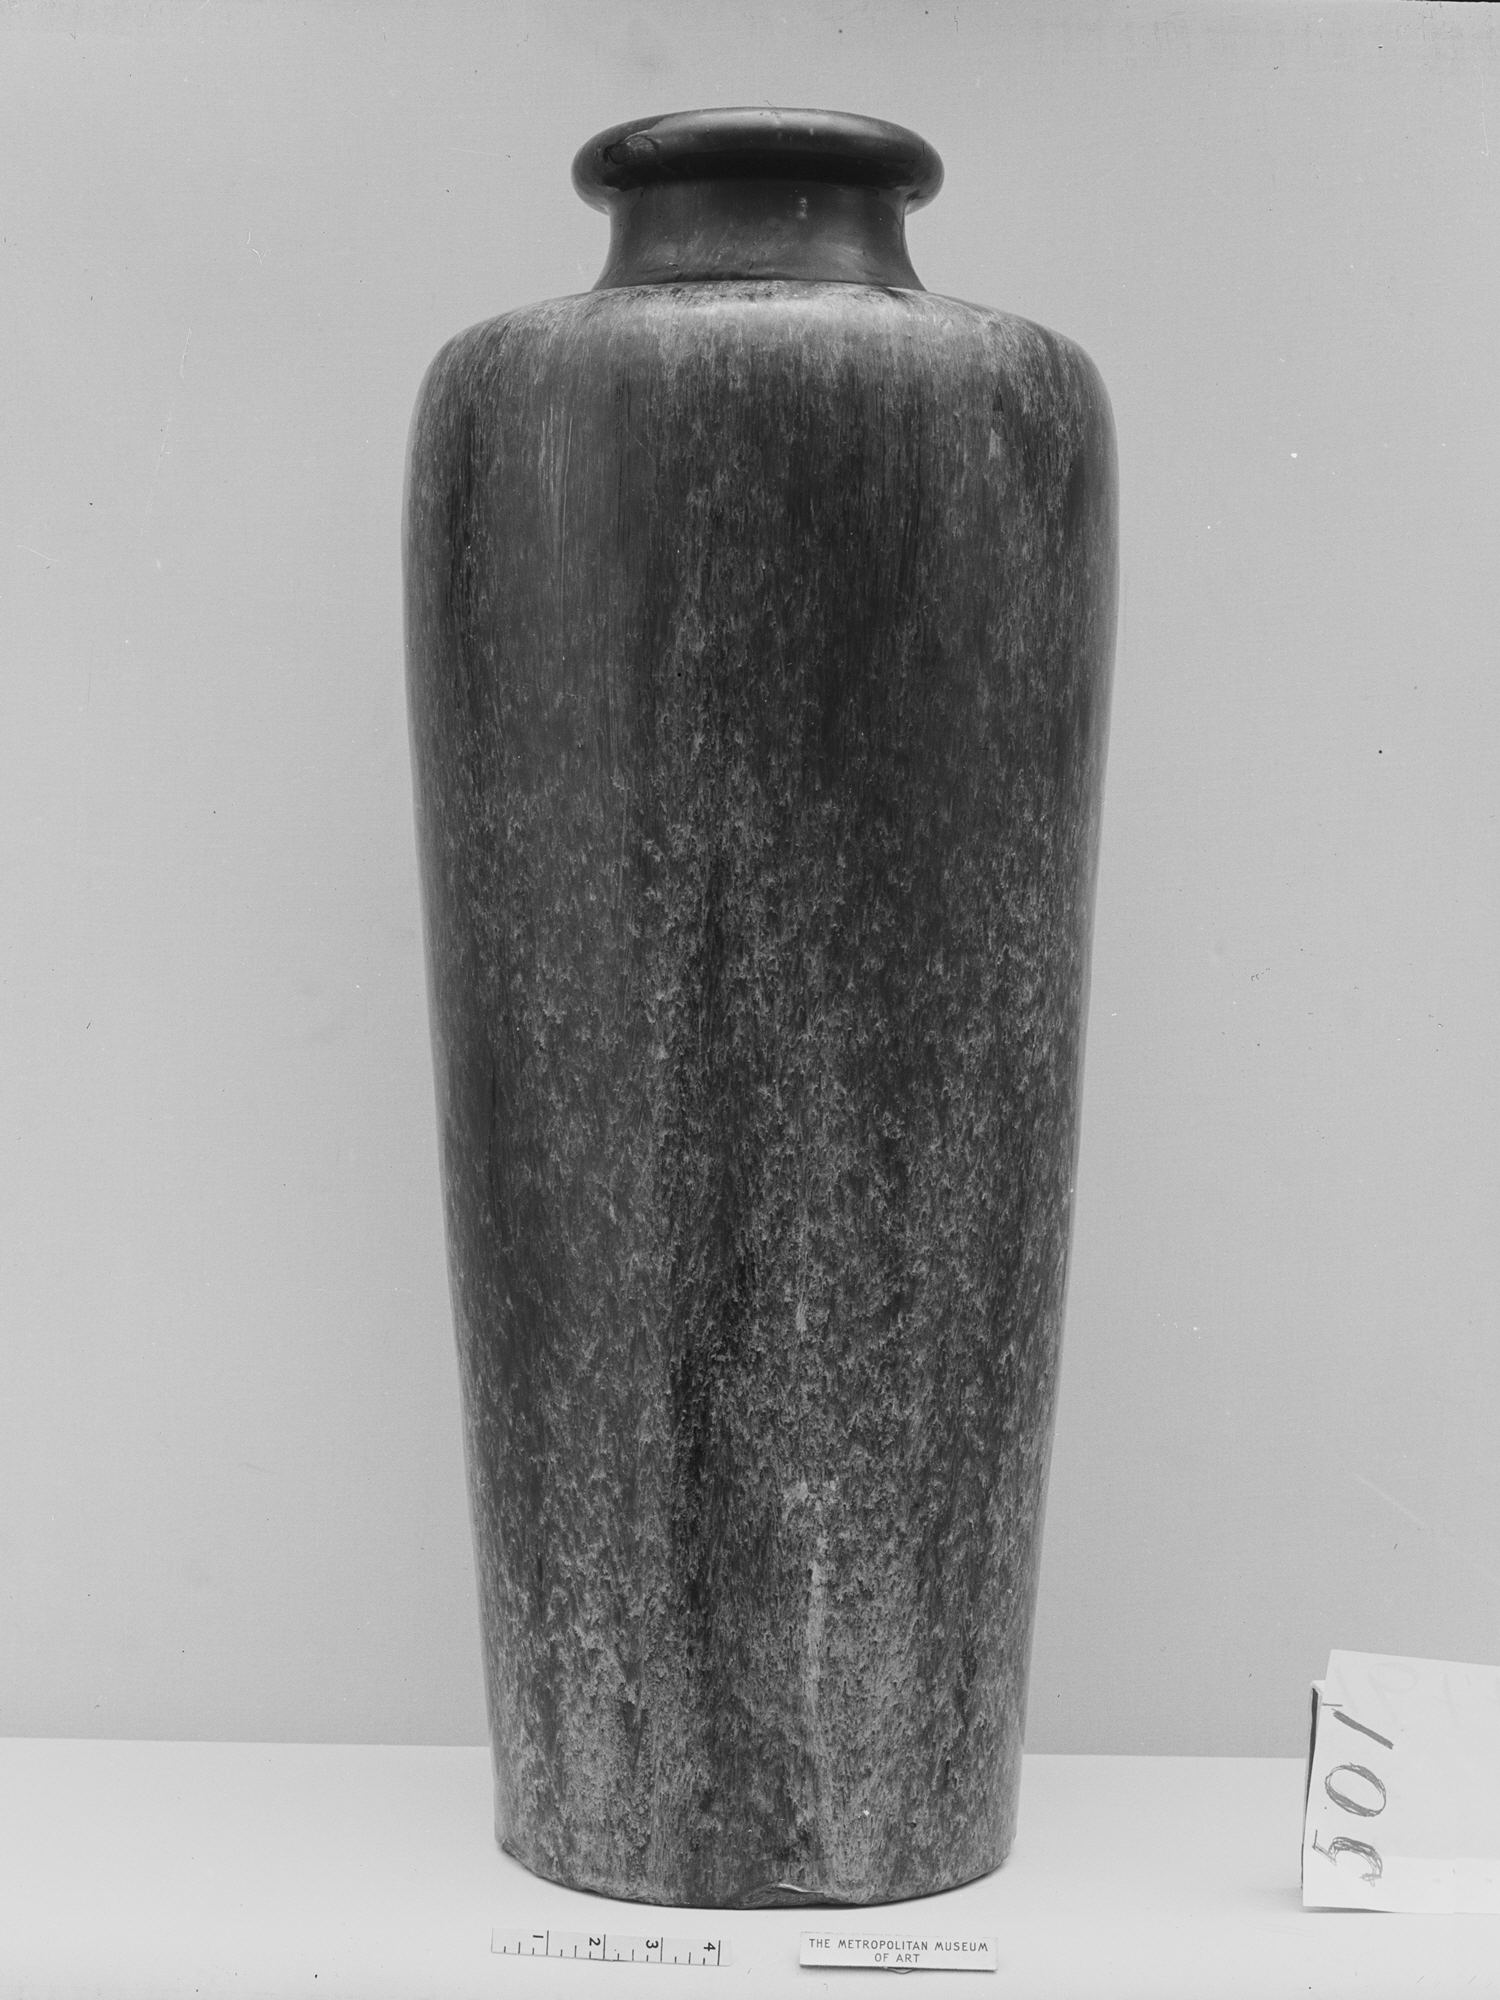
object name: vase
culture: chinese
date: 1801-1900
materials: glaze, porcelain